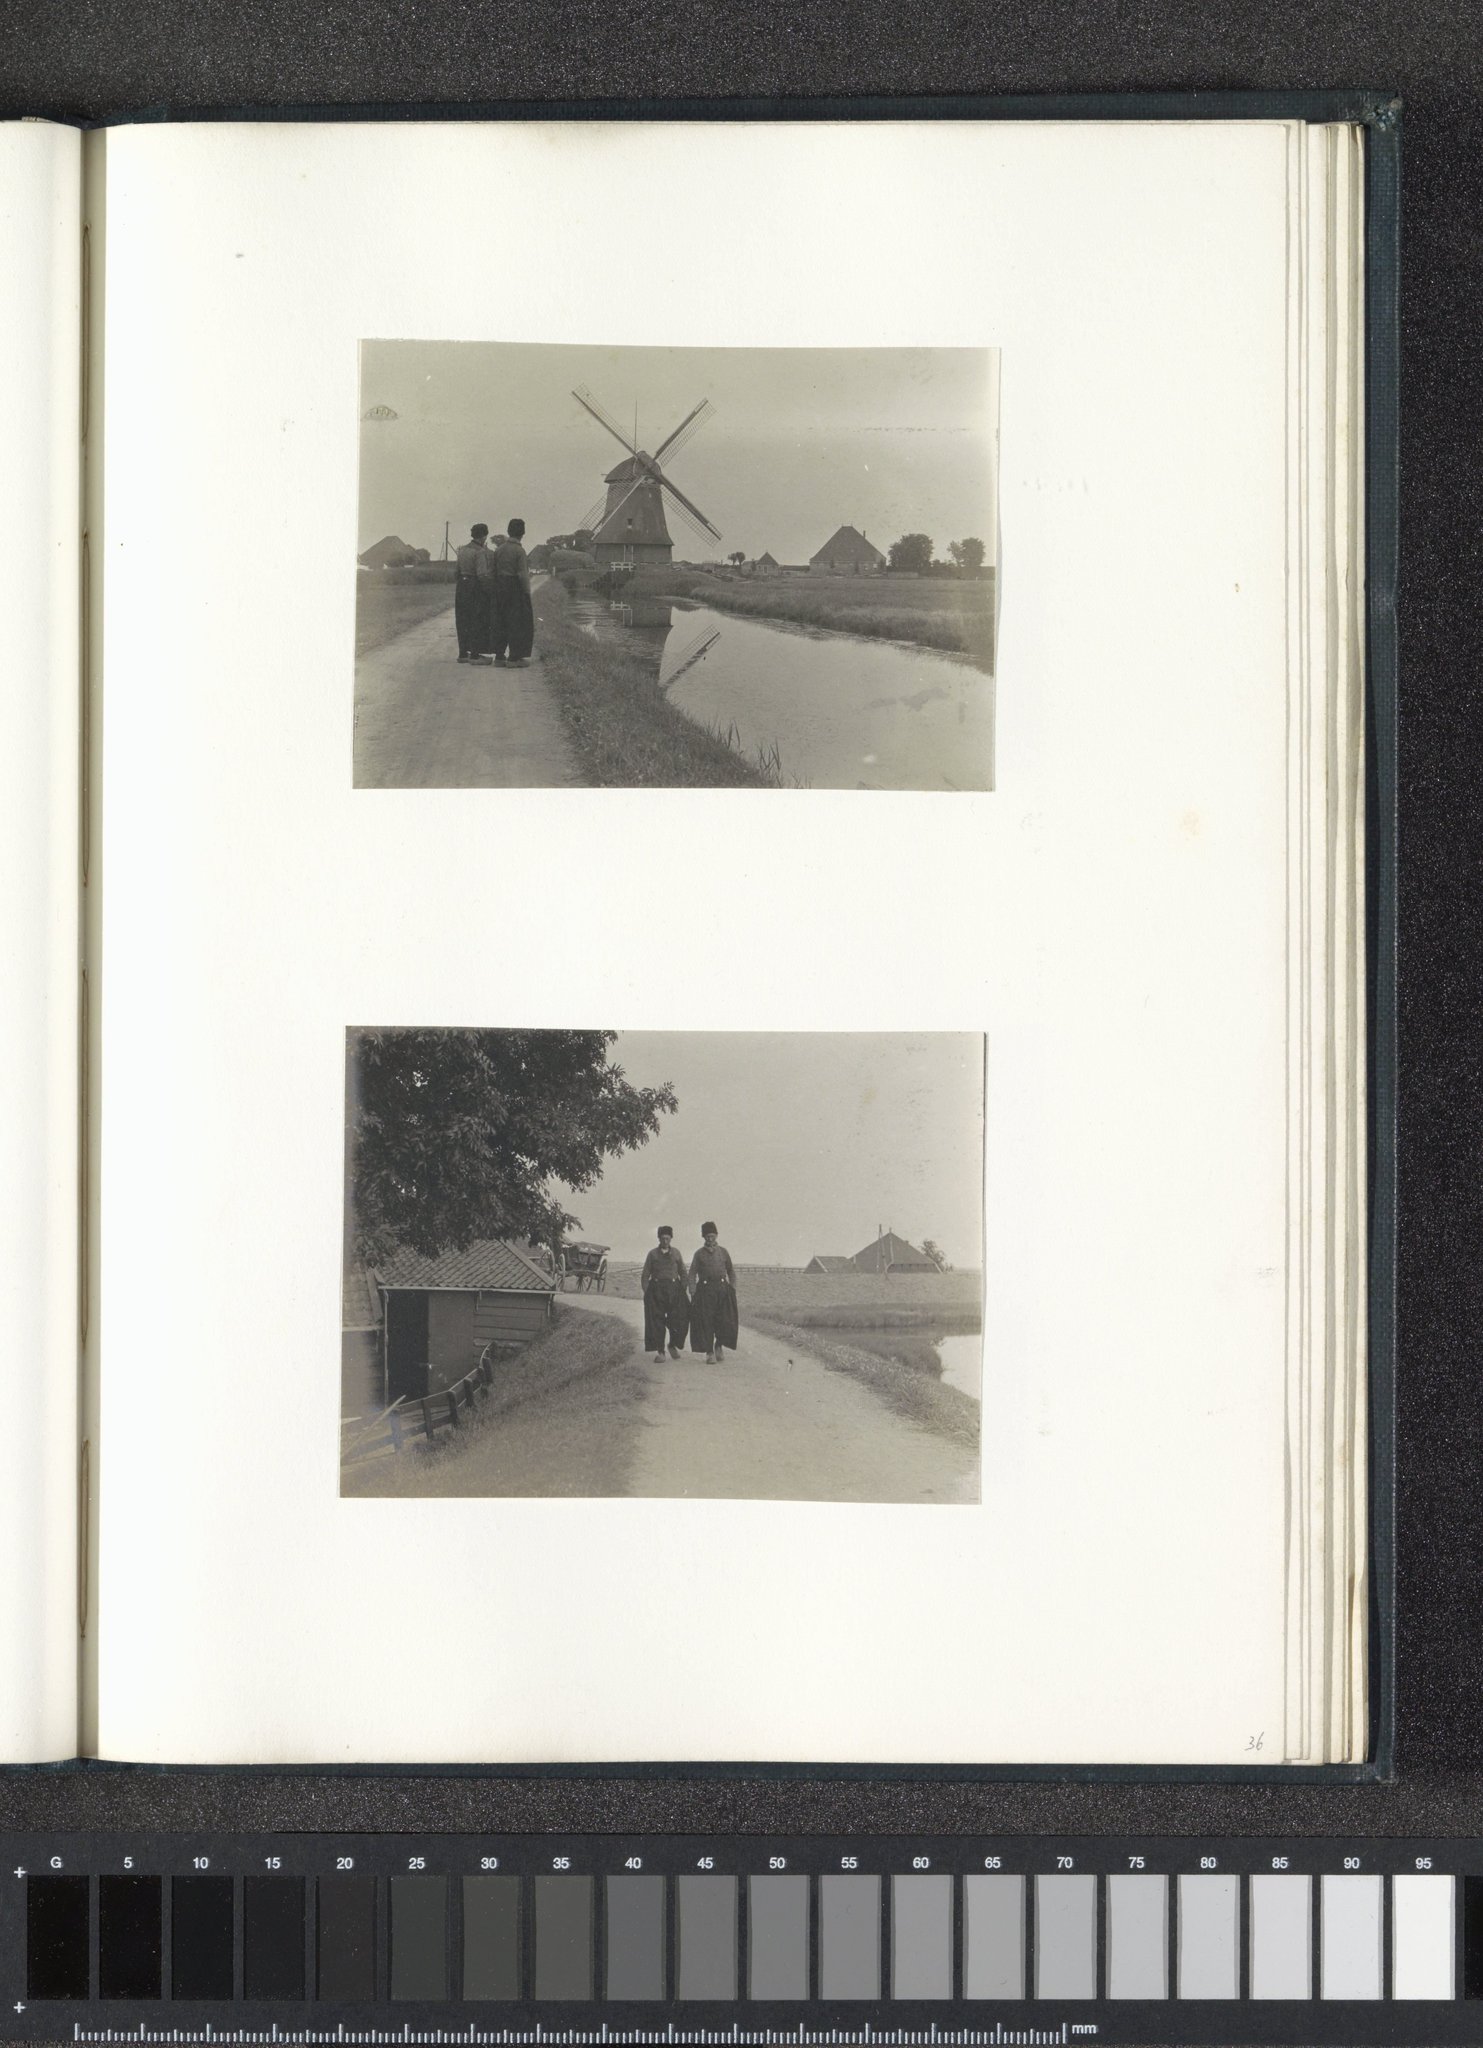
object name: photograph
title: Twee mannen in Volendamse klederdracht staand bij een sloot met op de achtergrond een molen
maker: george hidderley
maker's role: fotograaf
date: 1900-1910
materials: paper, photographic support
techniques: gelatin silver print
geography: volendam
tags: folk costume, regional costume (+ men's clothes), windmill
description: Onderdeel van fotoalbum met opnames van Volendam, Dordrecht, Gorinchem en Woudrichem.